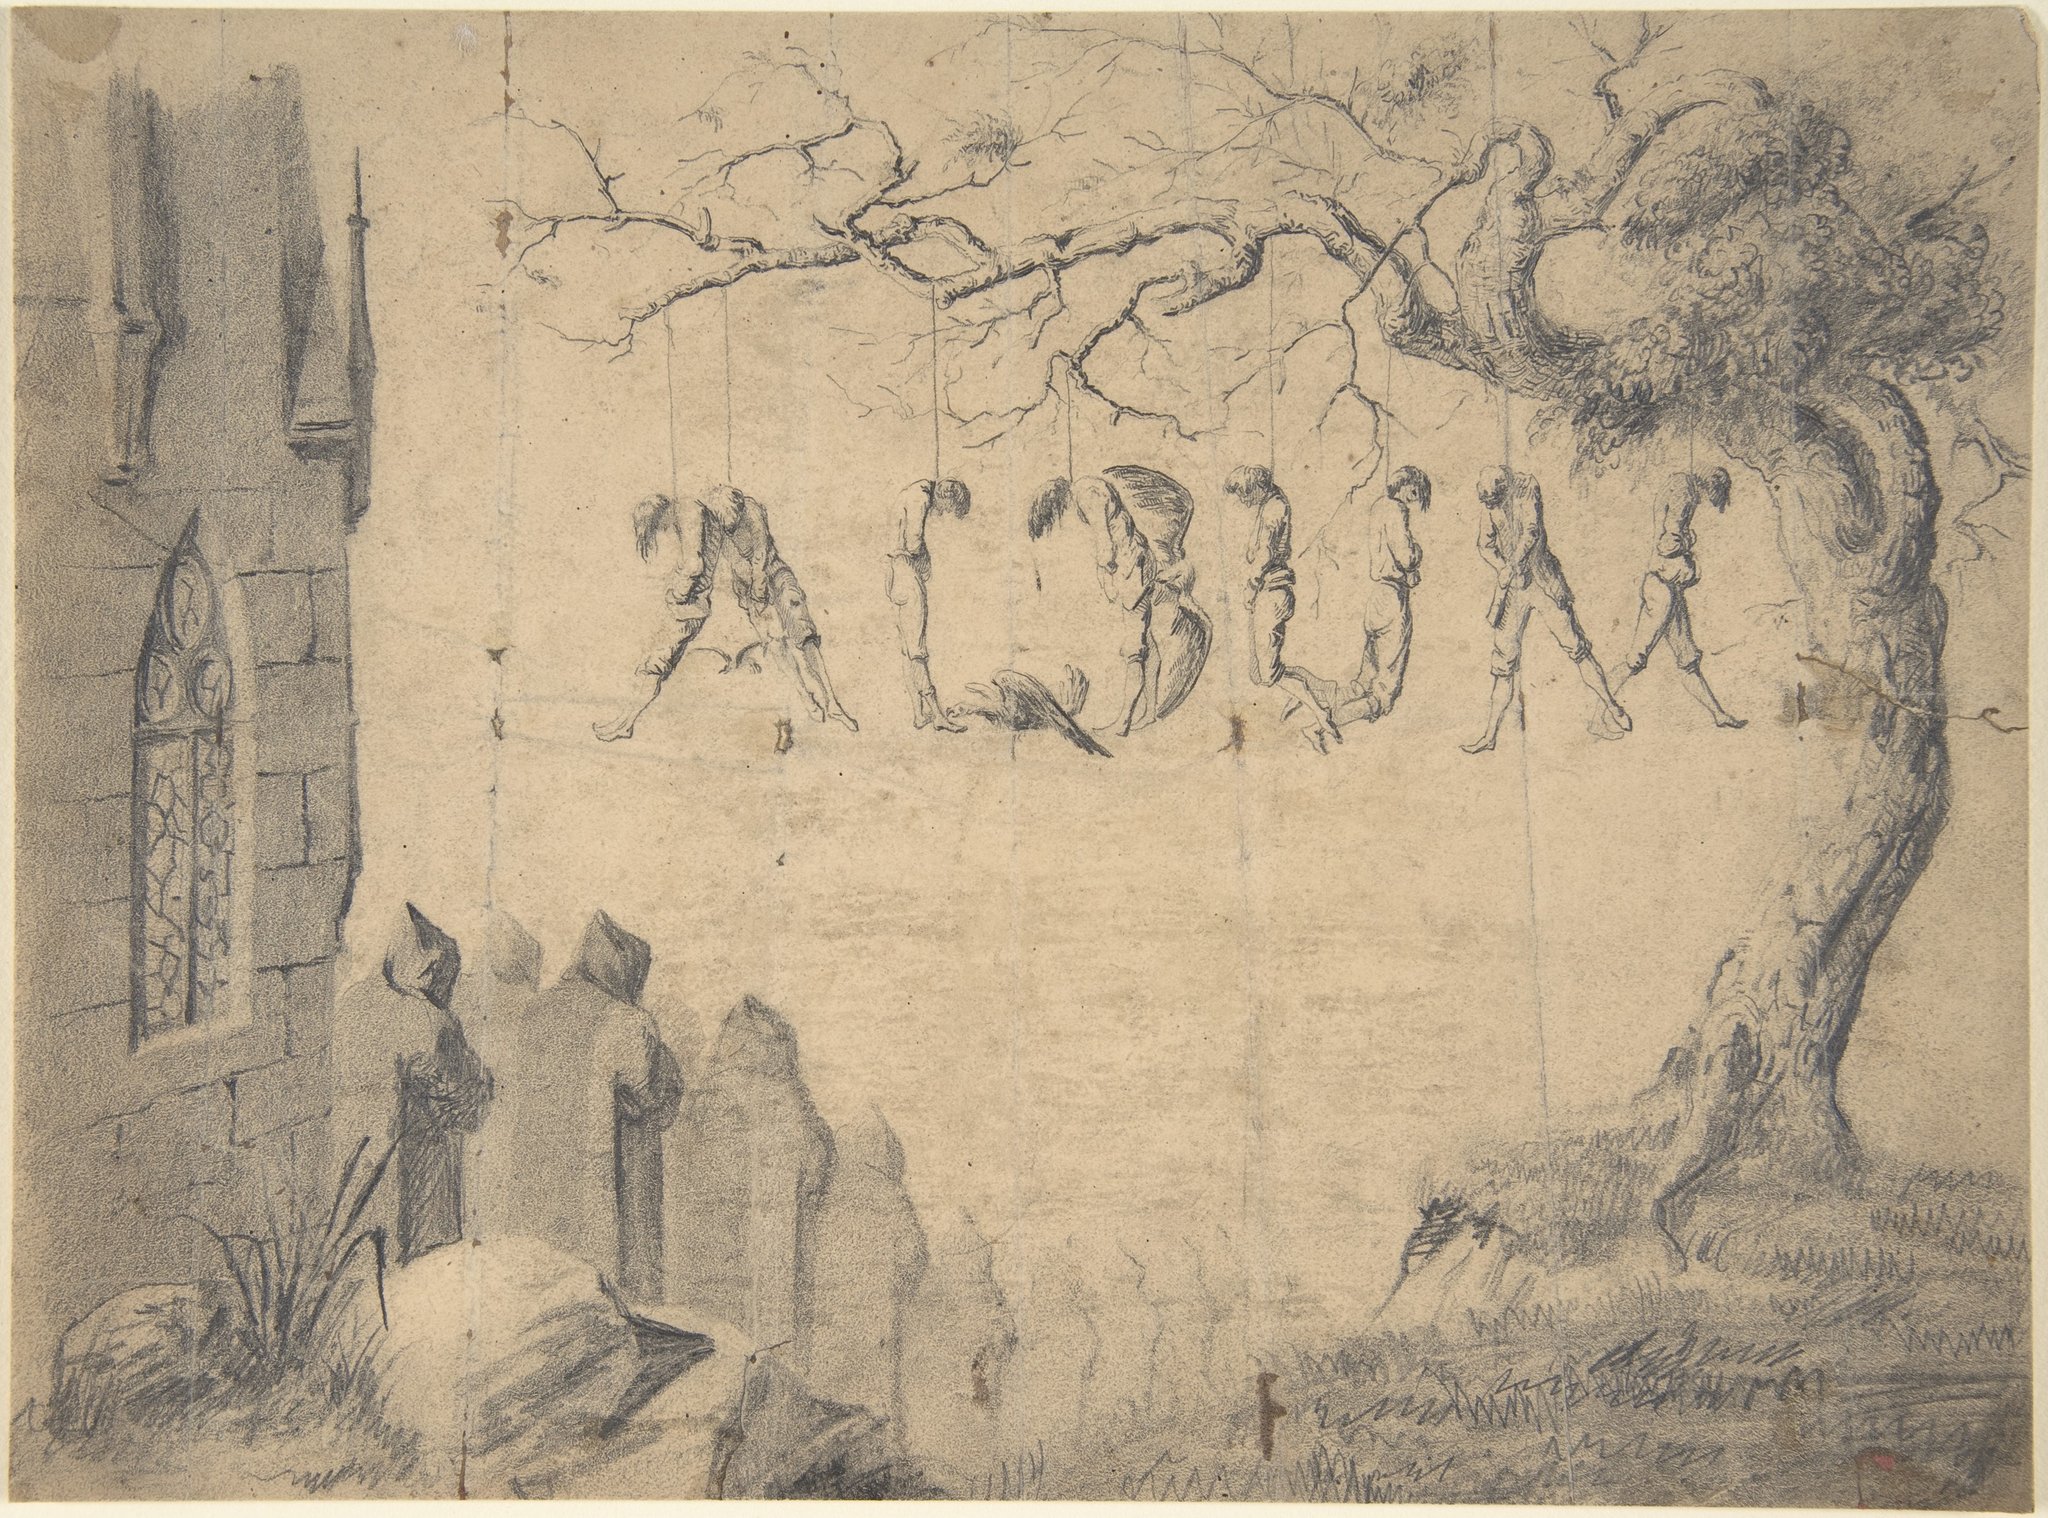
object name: drawing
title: Album Title Page: Hanging Scene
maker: anonymous, french, 19th century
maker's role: artist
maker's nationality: french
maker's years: 1800-1900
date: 1801-1900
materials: graphite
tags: eagles,corpses,trees,death,execution